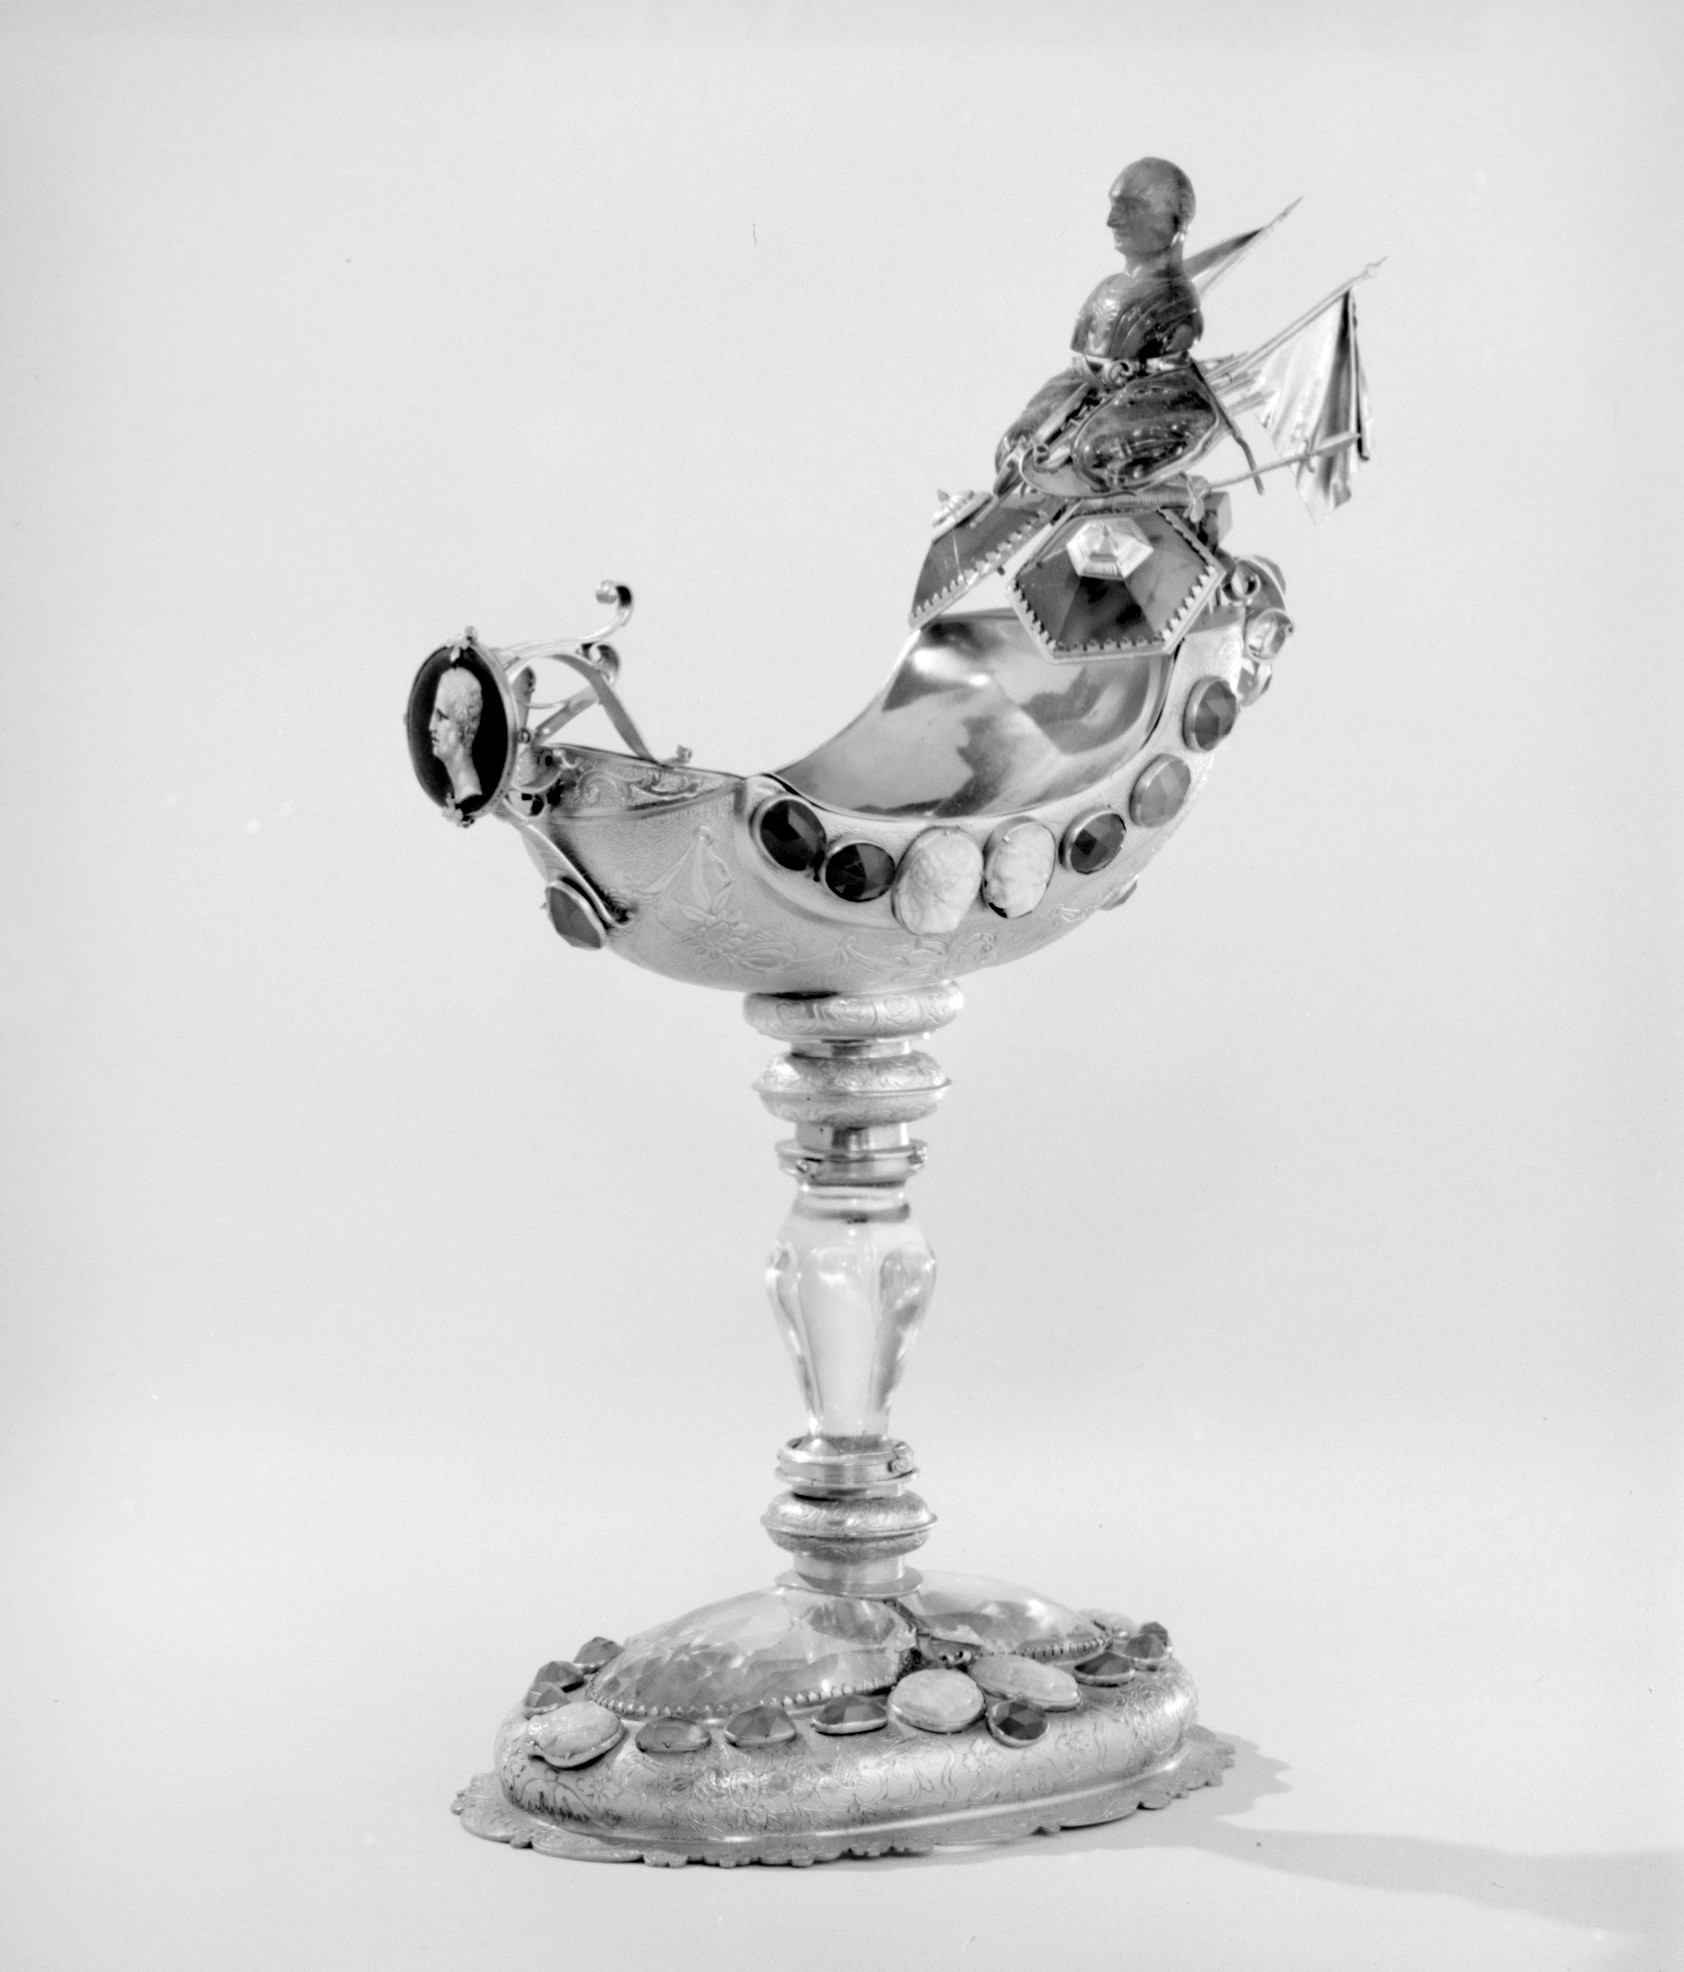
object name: stem cup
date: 1860-1880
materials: stone, gemstone, enamel, glass, silver gilt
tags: men,profiles